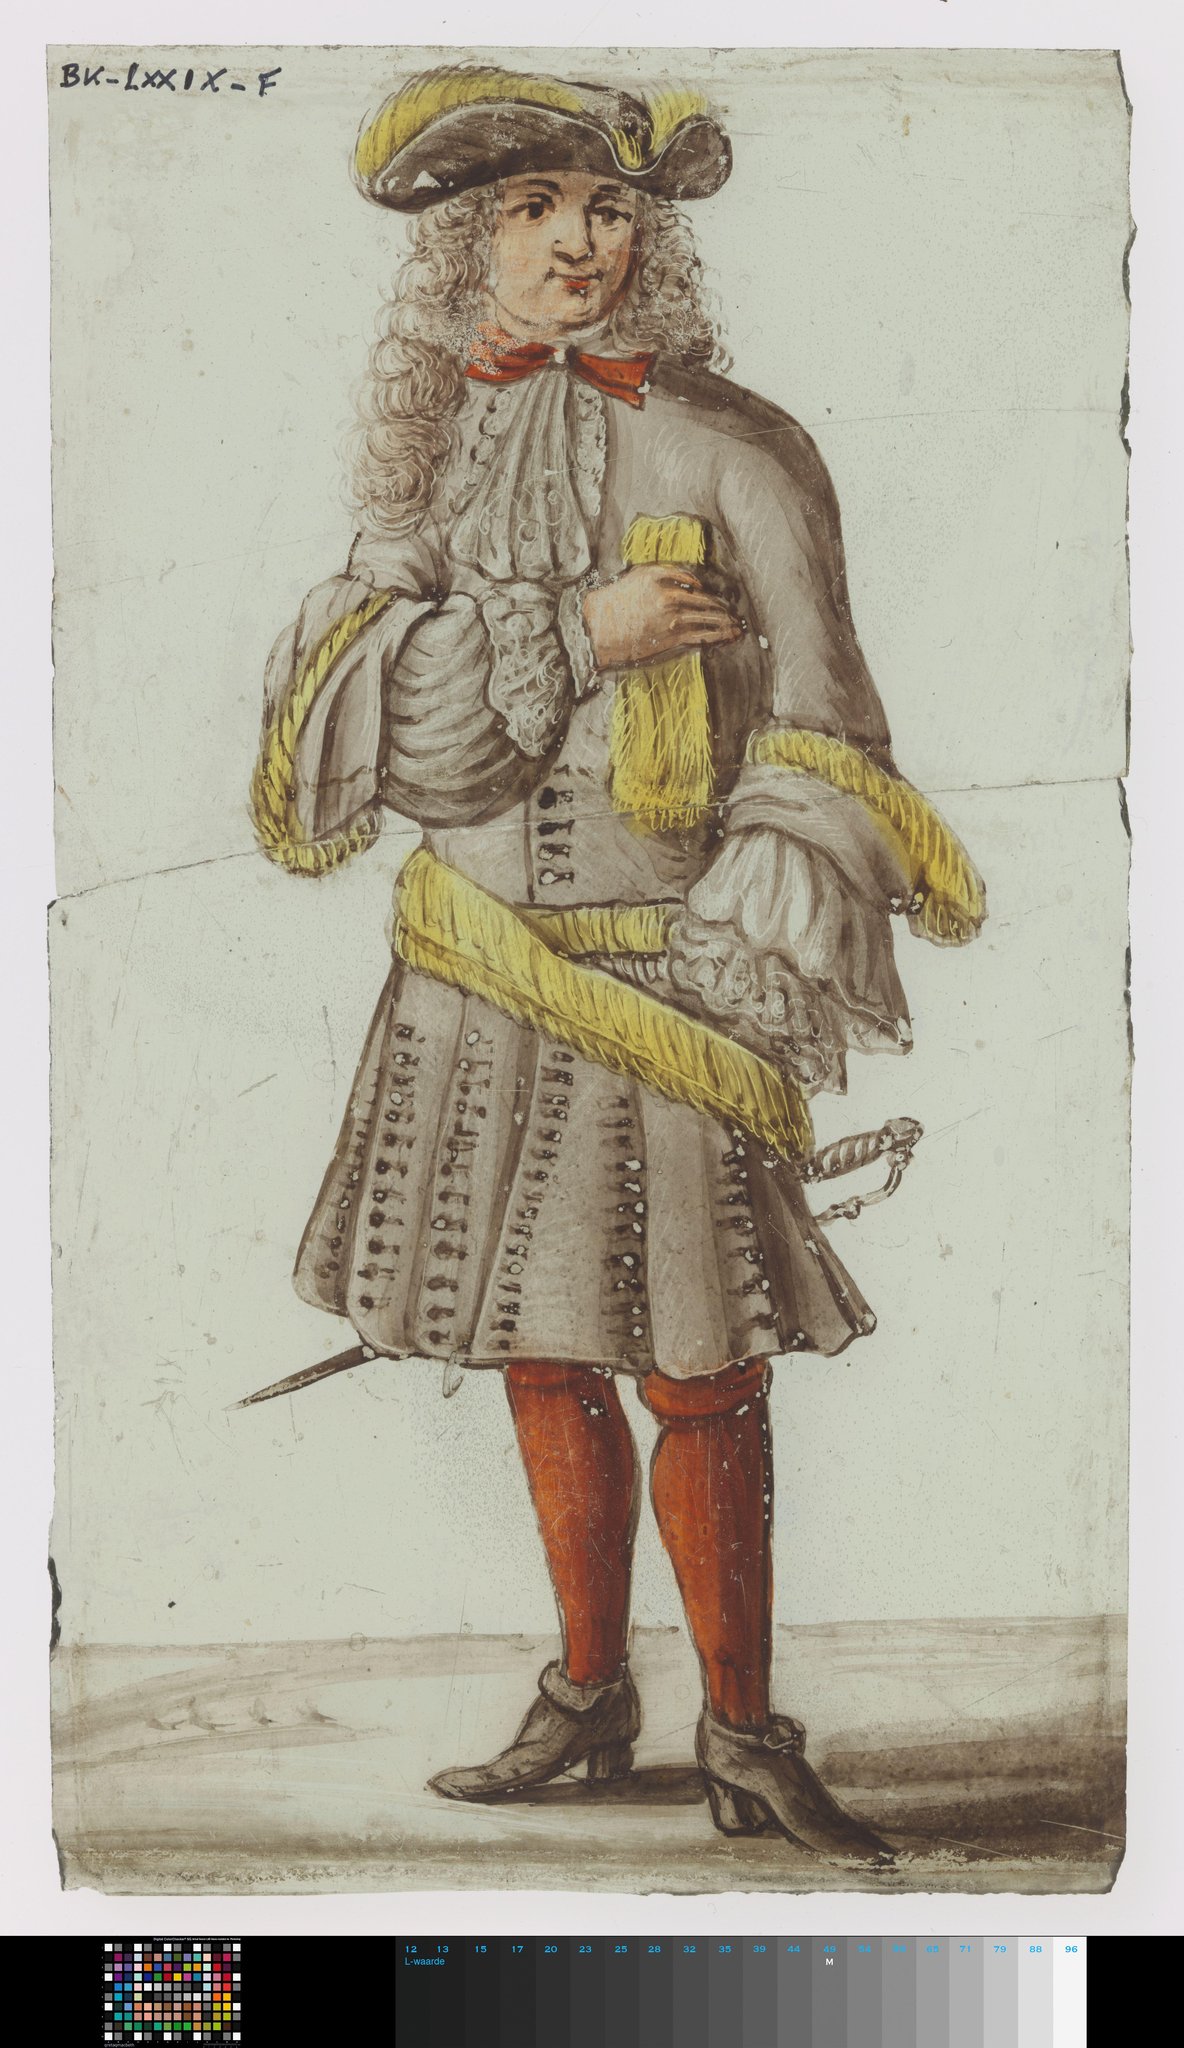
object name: light window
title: Ruit met een edelman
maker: Anonymous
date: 1650-1675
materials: glass, lead, pigment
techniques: enamel painting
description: Een ruitje met emailschildering van een edelman in een rijk kostuum van ca. 1670, in grisaille, rood en geel.